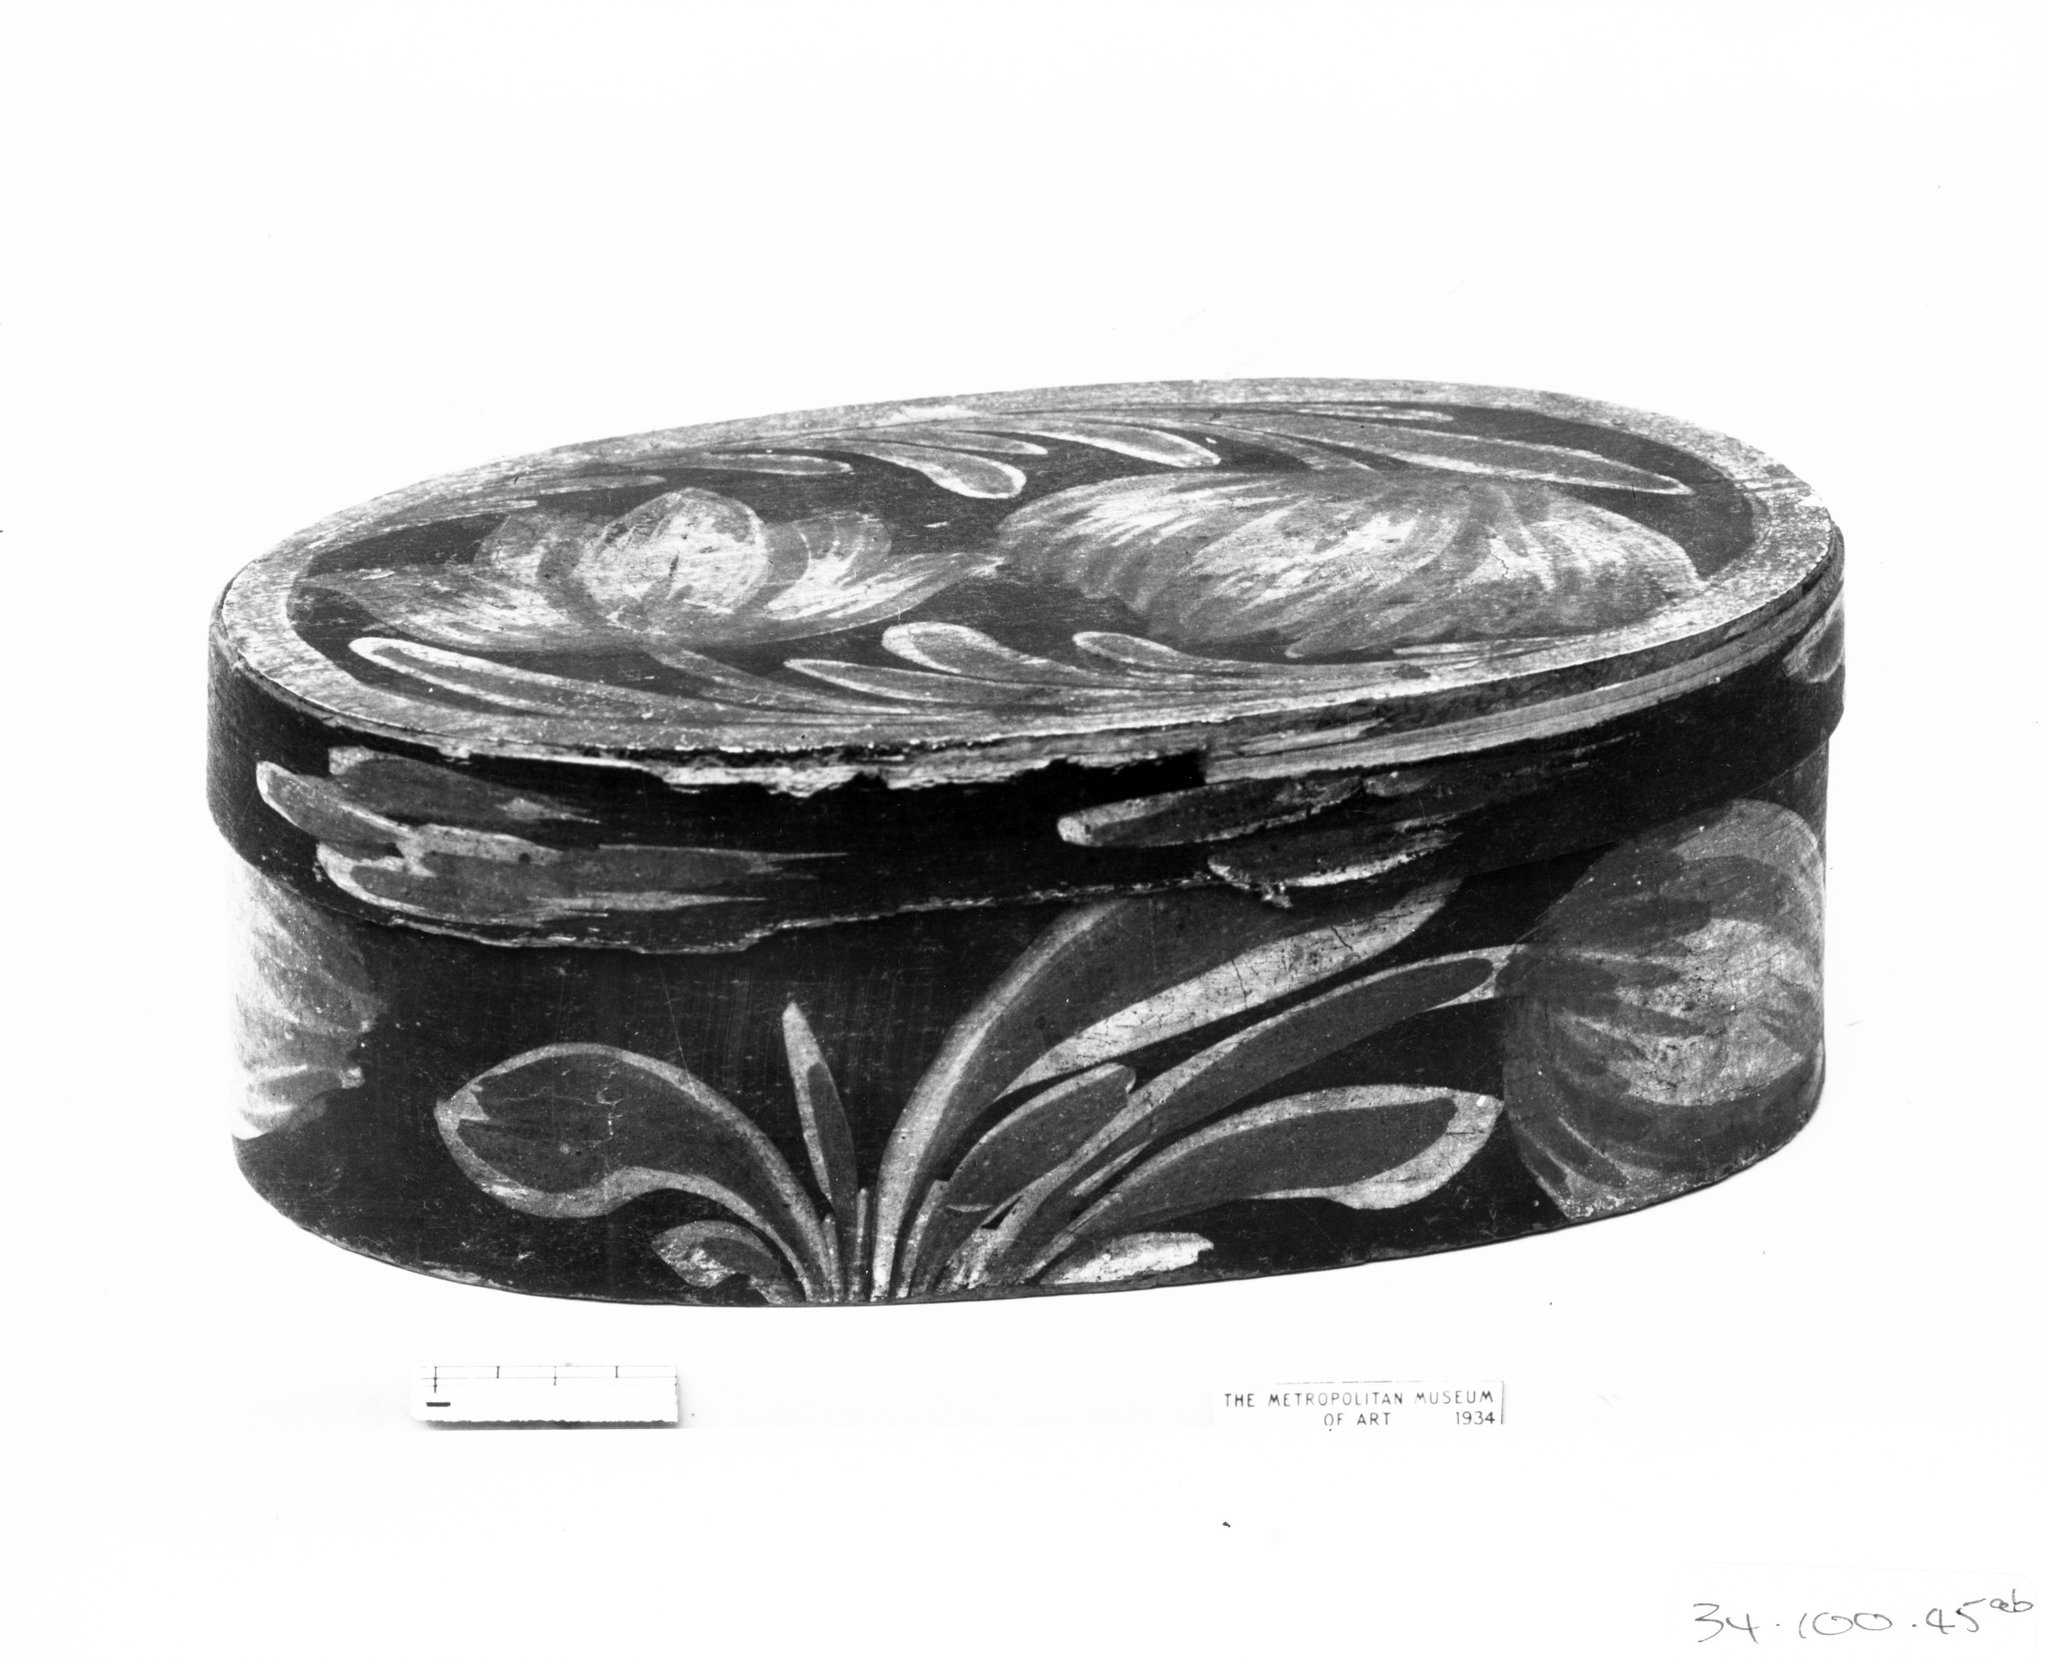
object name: trinket box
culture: american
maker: henry bucher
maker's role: maker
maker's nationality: american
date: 1780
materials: wood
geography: united states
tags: flowers